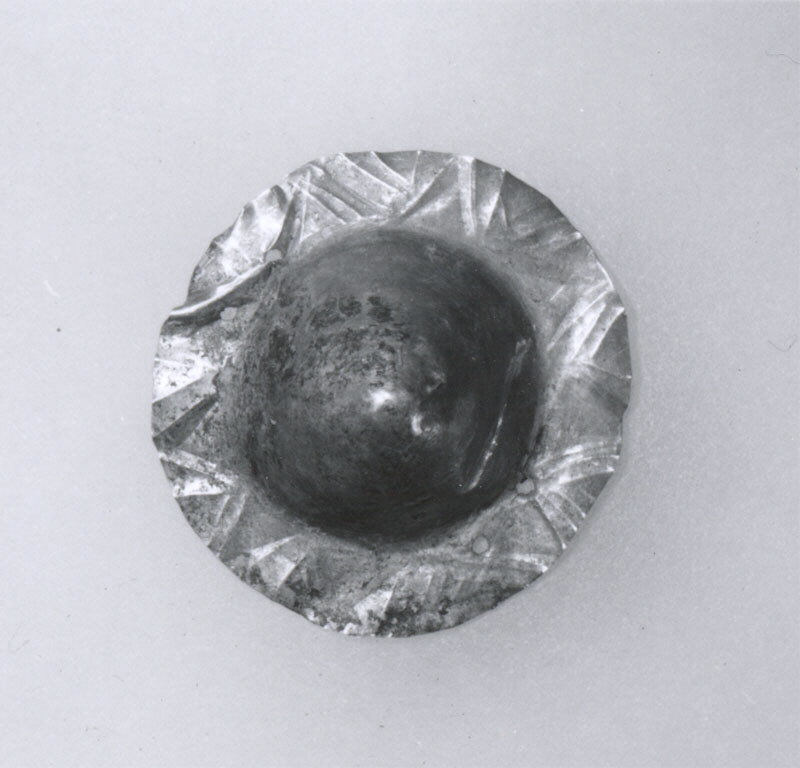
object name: bos or appliqué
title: Boss or appliqué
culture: iranian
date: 1-1000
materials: gold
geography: iran